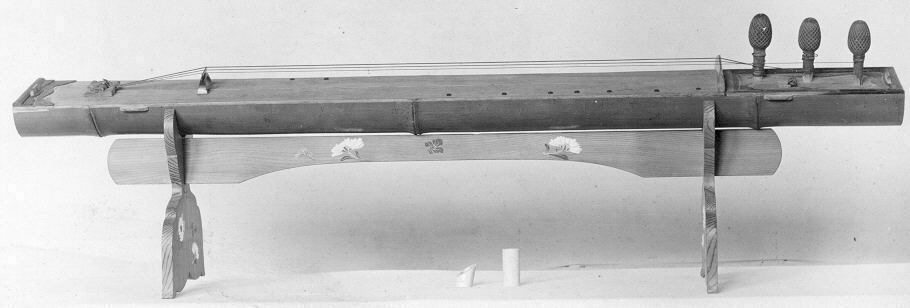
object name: sangenkin 三弦琴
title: Sangenkin ( 三弦琴 )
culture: japanese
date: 1801-1900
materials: bamboo, ivory, silk, wood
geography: japan